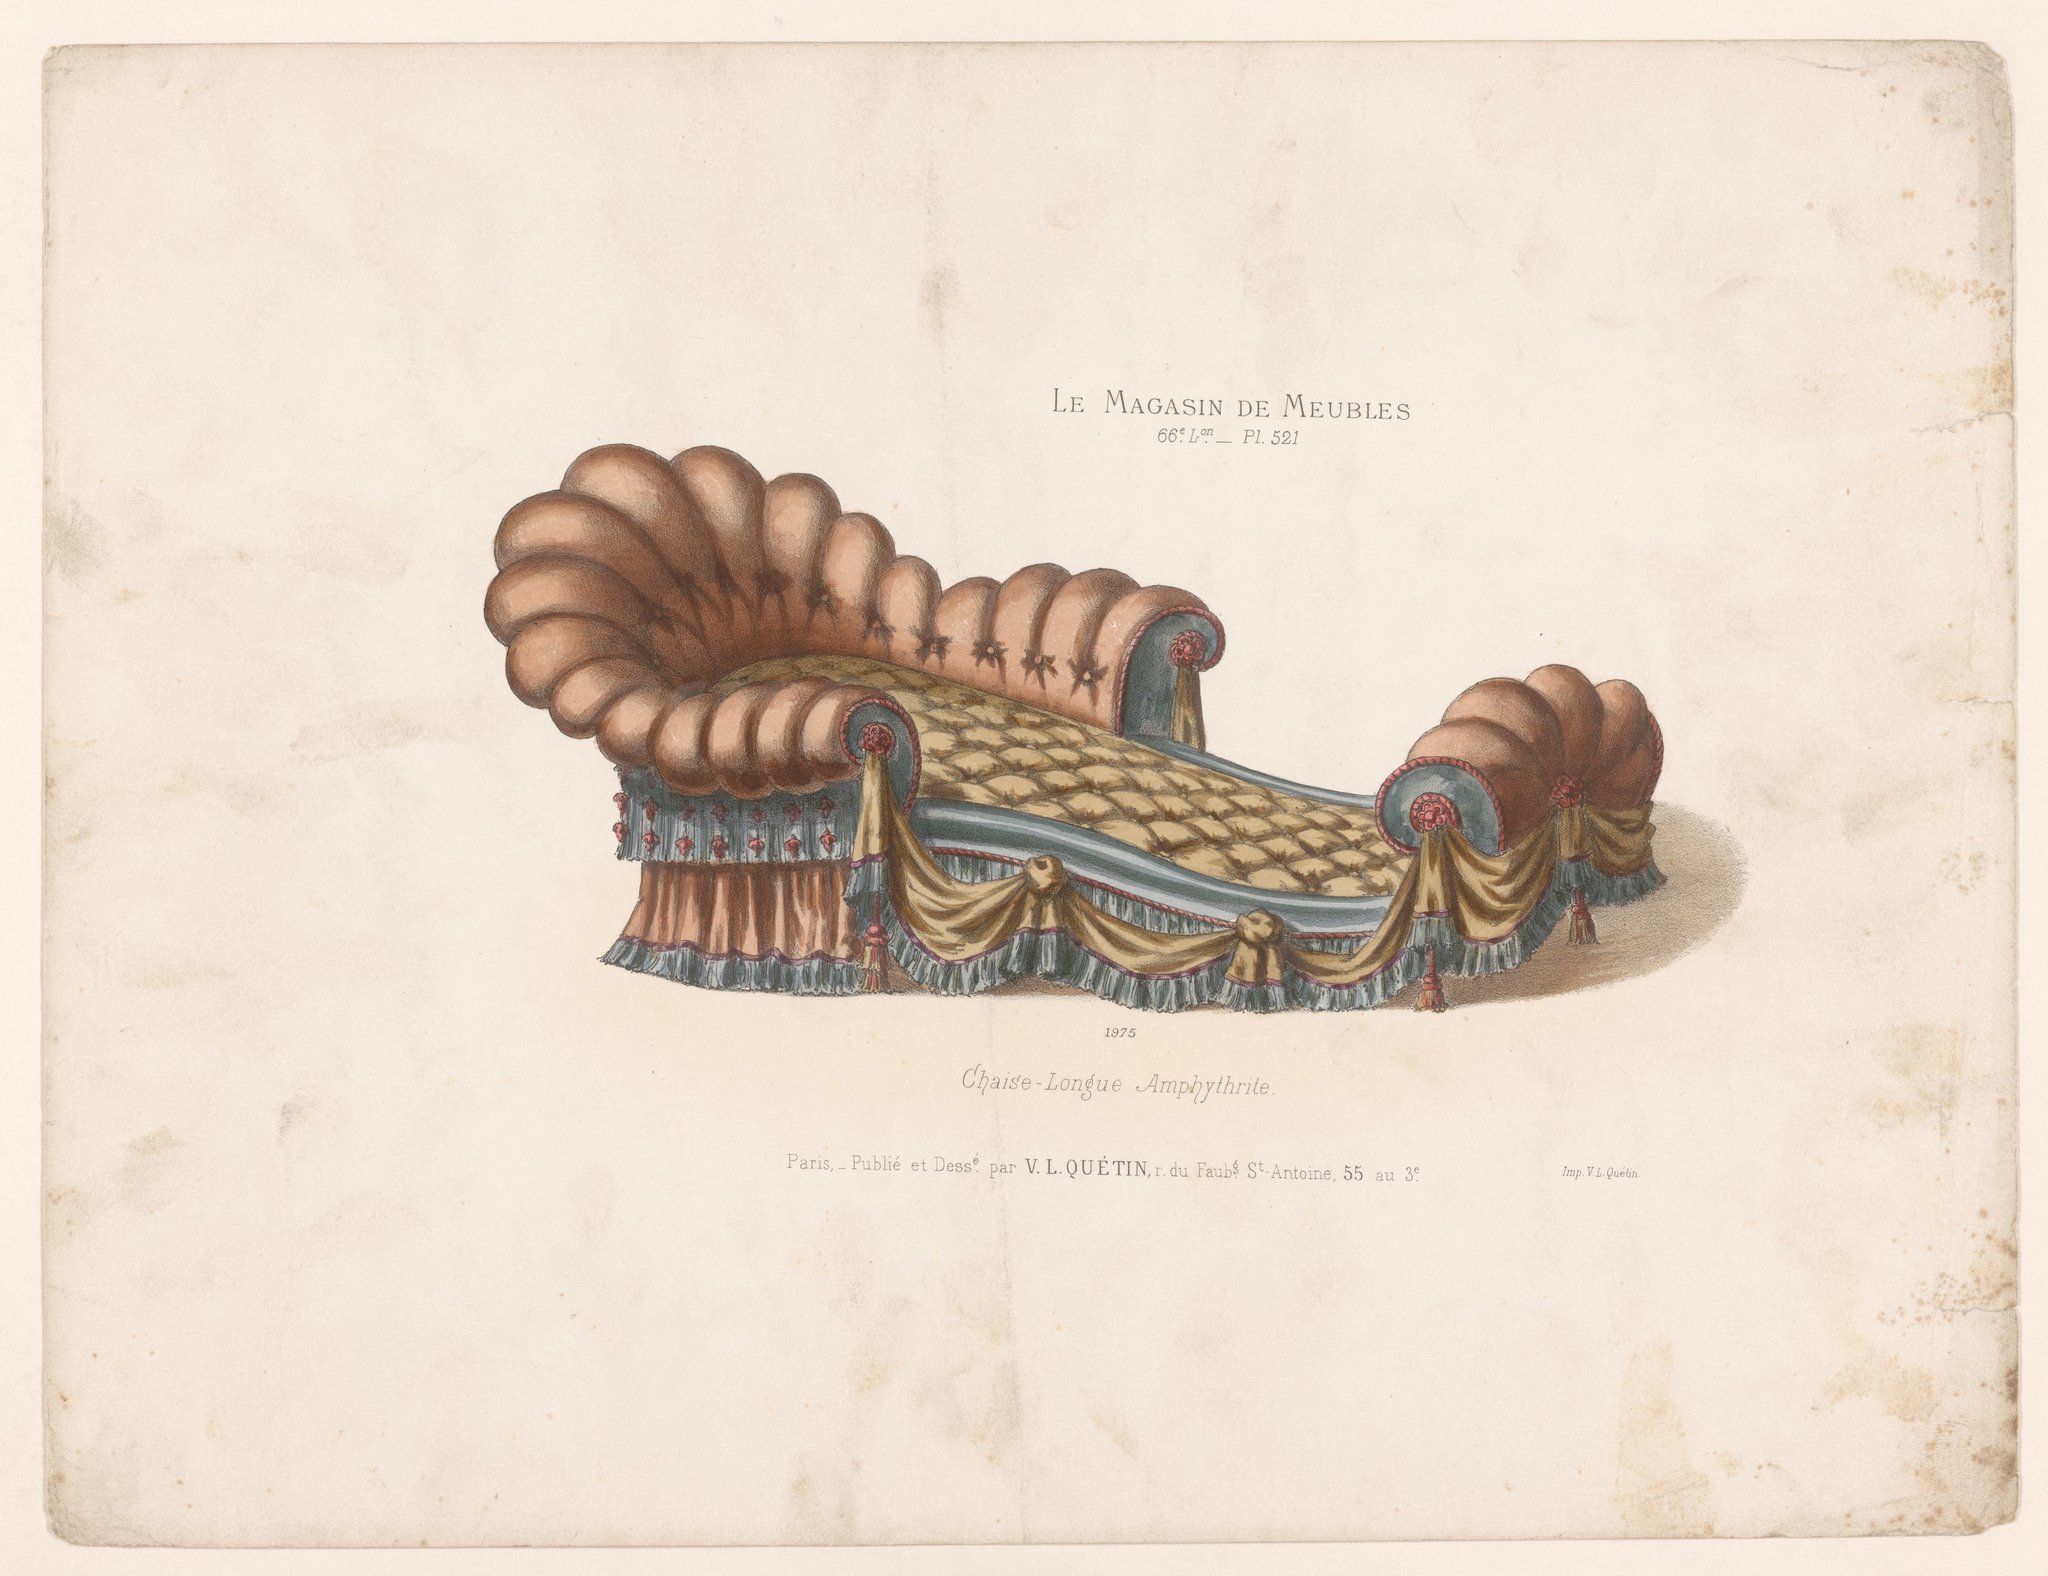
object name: print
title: Chaise longue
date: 1878-1904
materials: paper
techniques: hand coloring, lithograph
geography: paris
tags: seating furniture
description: Een chaise longue. Prent uit 66e Livraison.